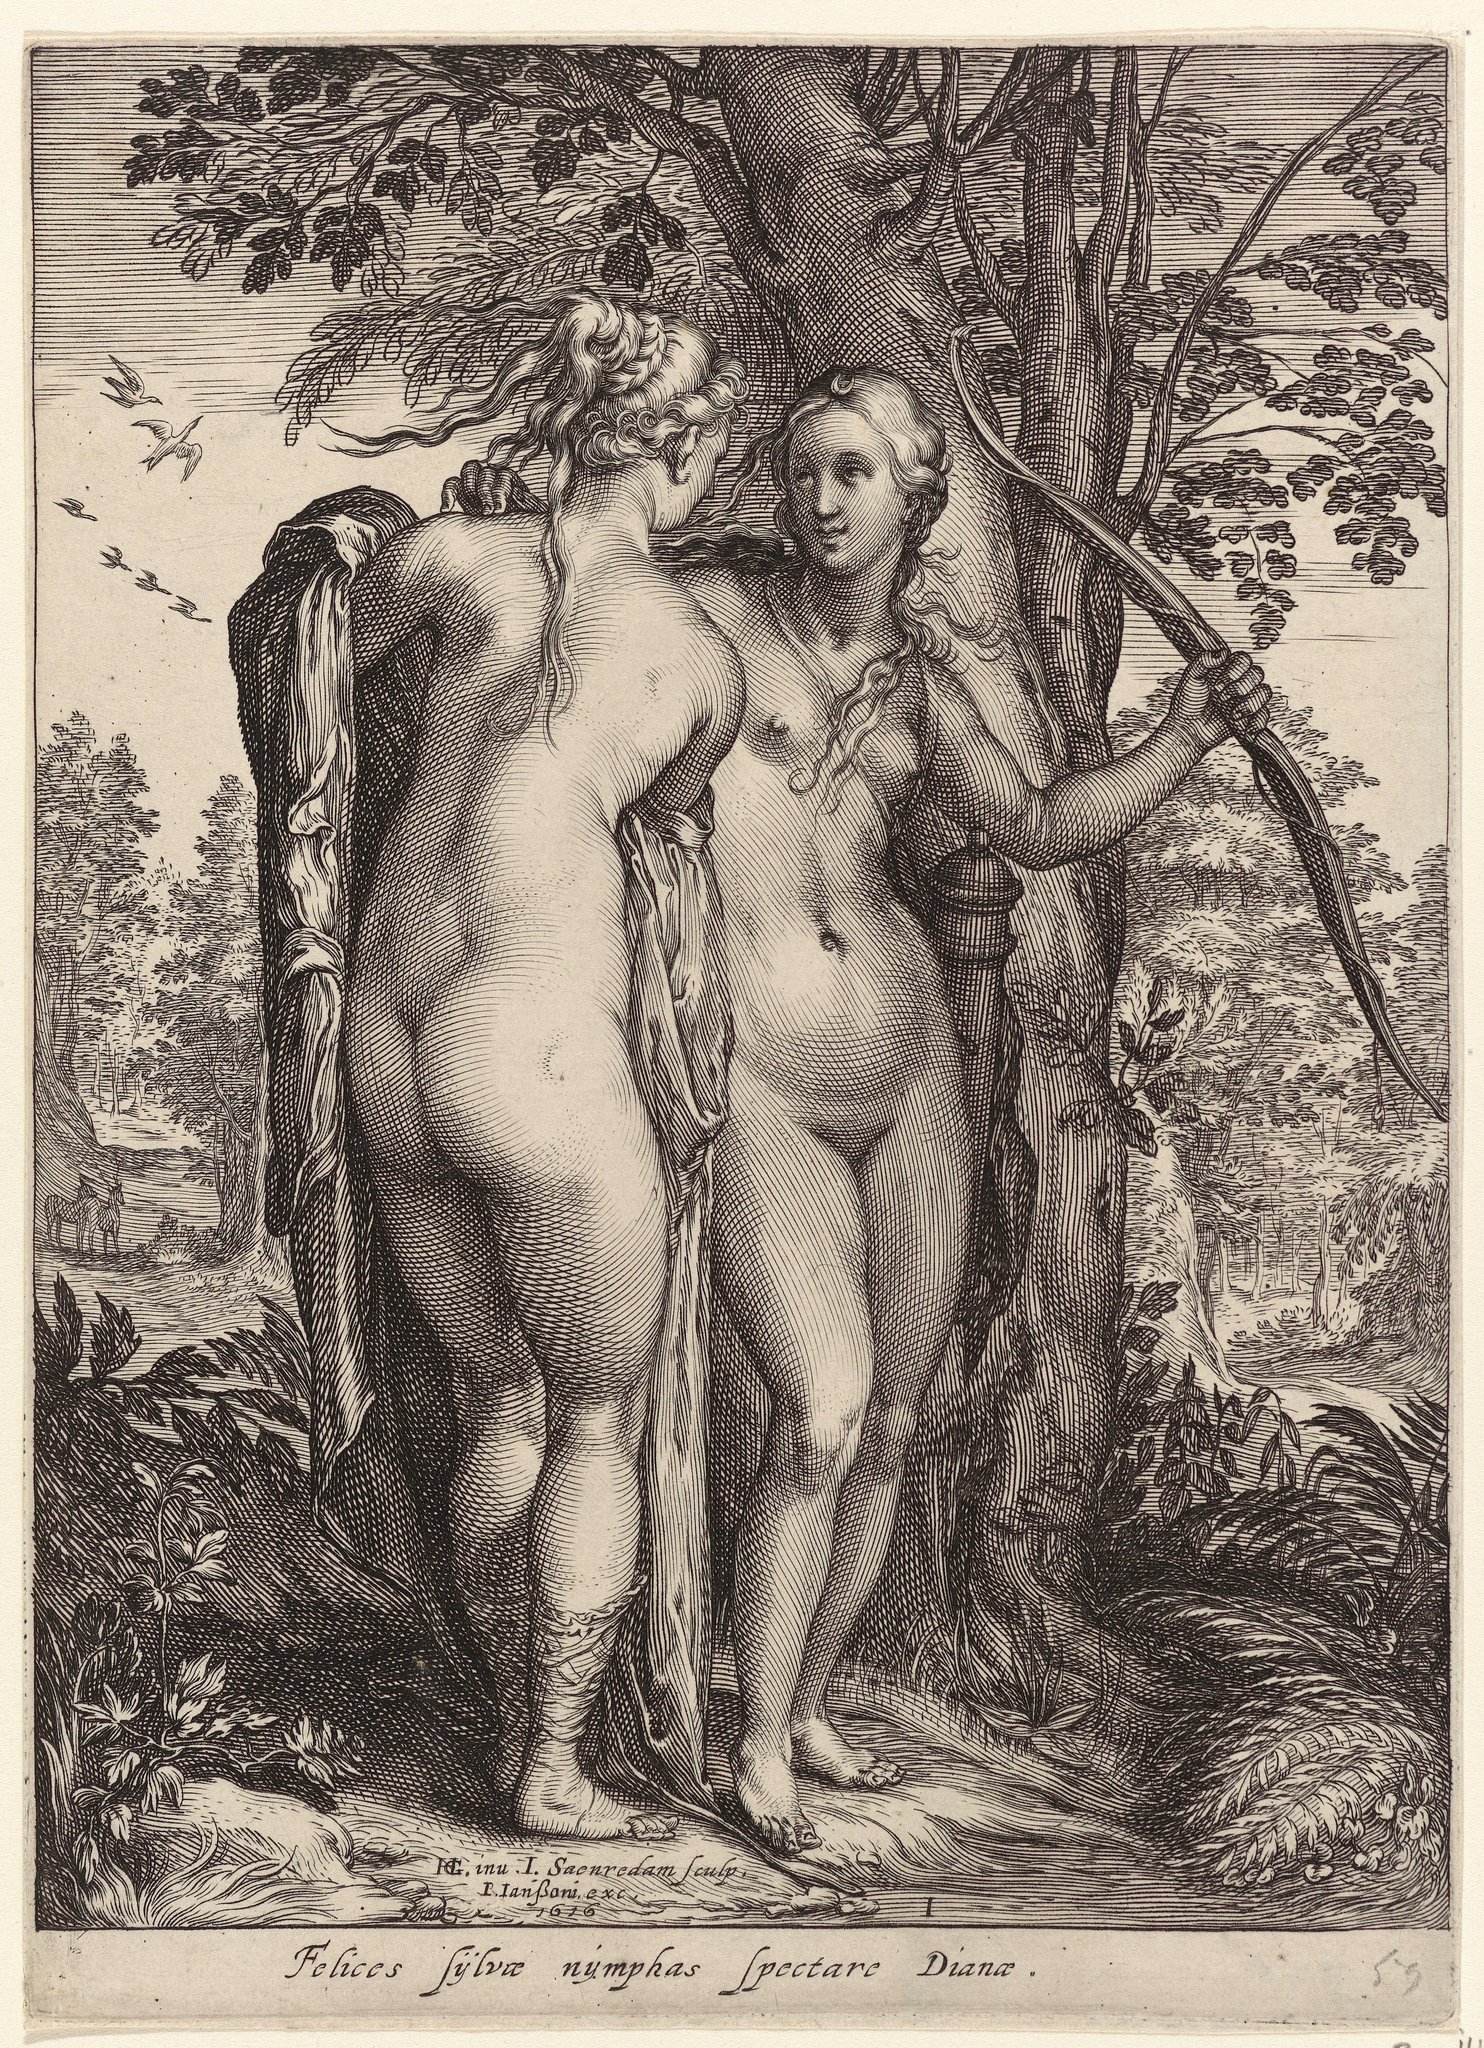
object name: print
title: Diana en haar nimfen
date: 1598-1665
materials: paper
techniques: engraving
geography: assendelft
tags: companions, nymphs of diana; 'ninfe di diana' (ripa), diana hunting with her nymphs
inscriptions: collector's mark: Lugt 240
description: Voor een boom staan de naakte Diana (met pijl en boog) en een van haar nimfen. De prent maakt deel uit van een driedelige serie van Diana en haar nimfen en heeft een Latijns onderschrift.